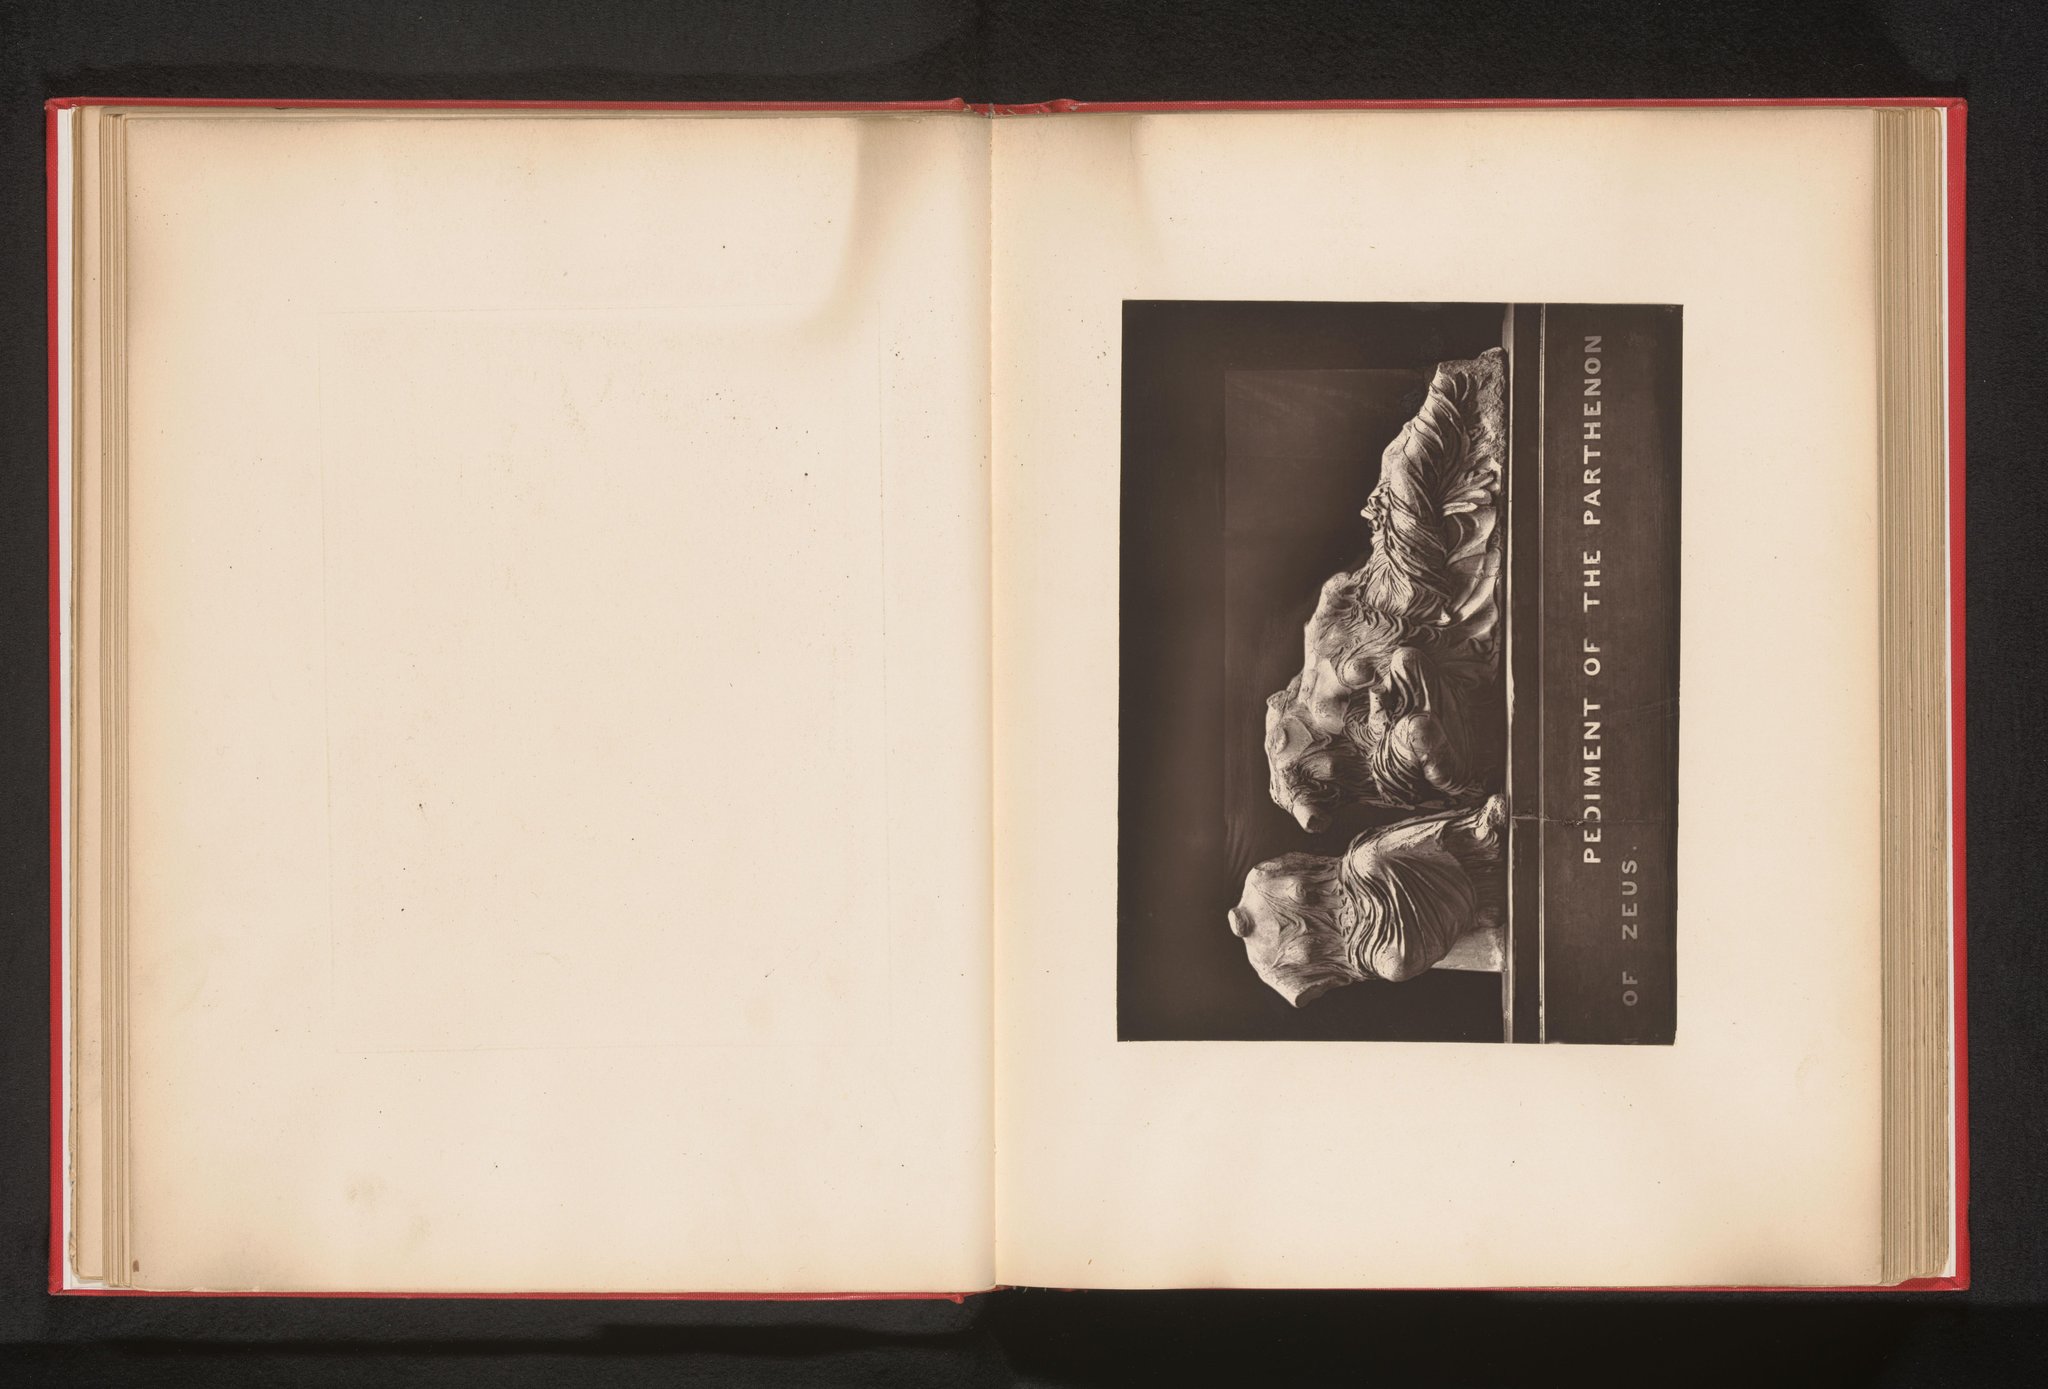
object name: page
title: Sculptuur van de Moira door Phidias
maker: stephen thompson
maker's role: fotograaf, schrijver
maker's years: 1831-1893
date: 1873-1878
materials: paper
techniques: woodburytype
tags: fates, parcae (moirae), sculpture